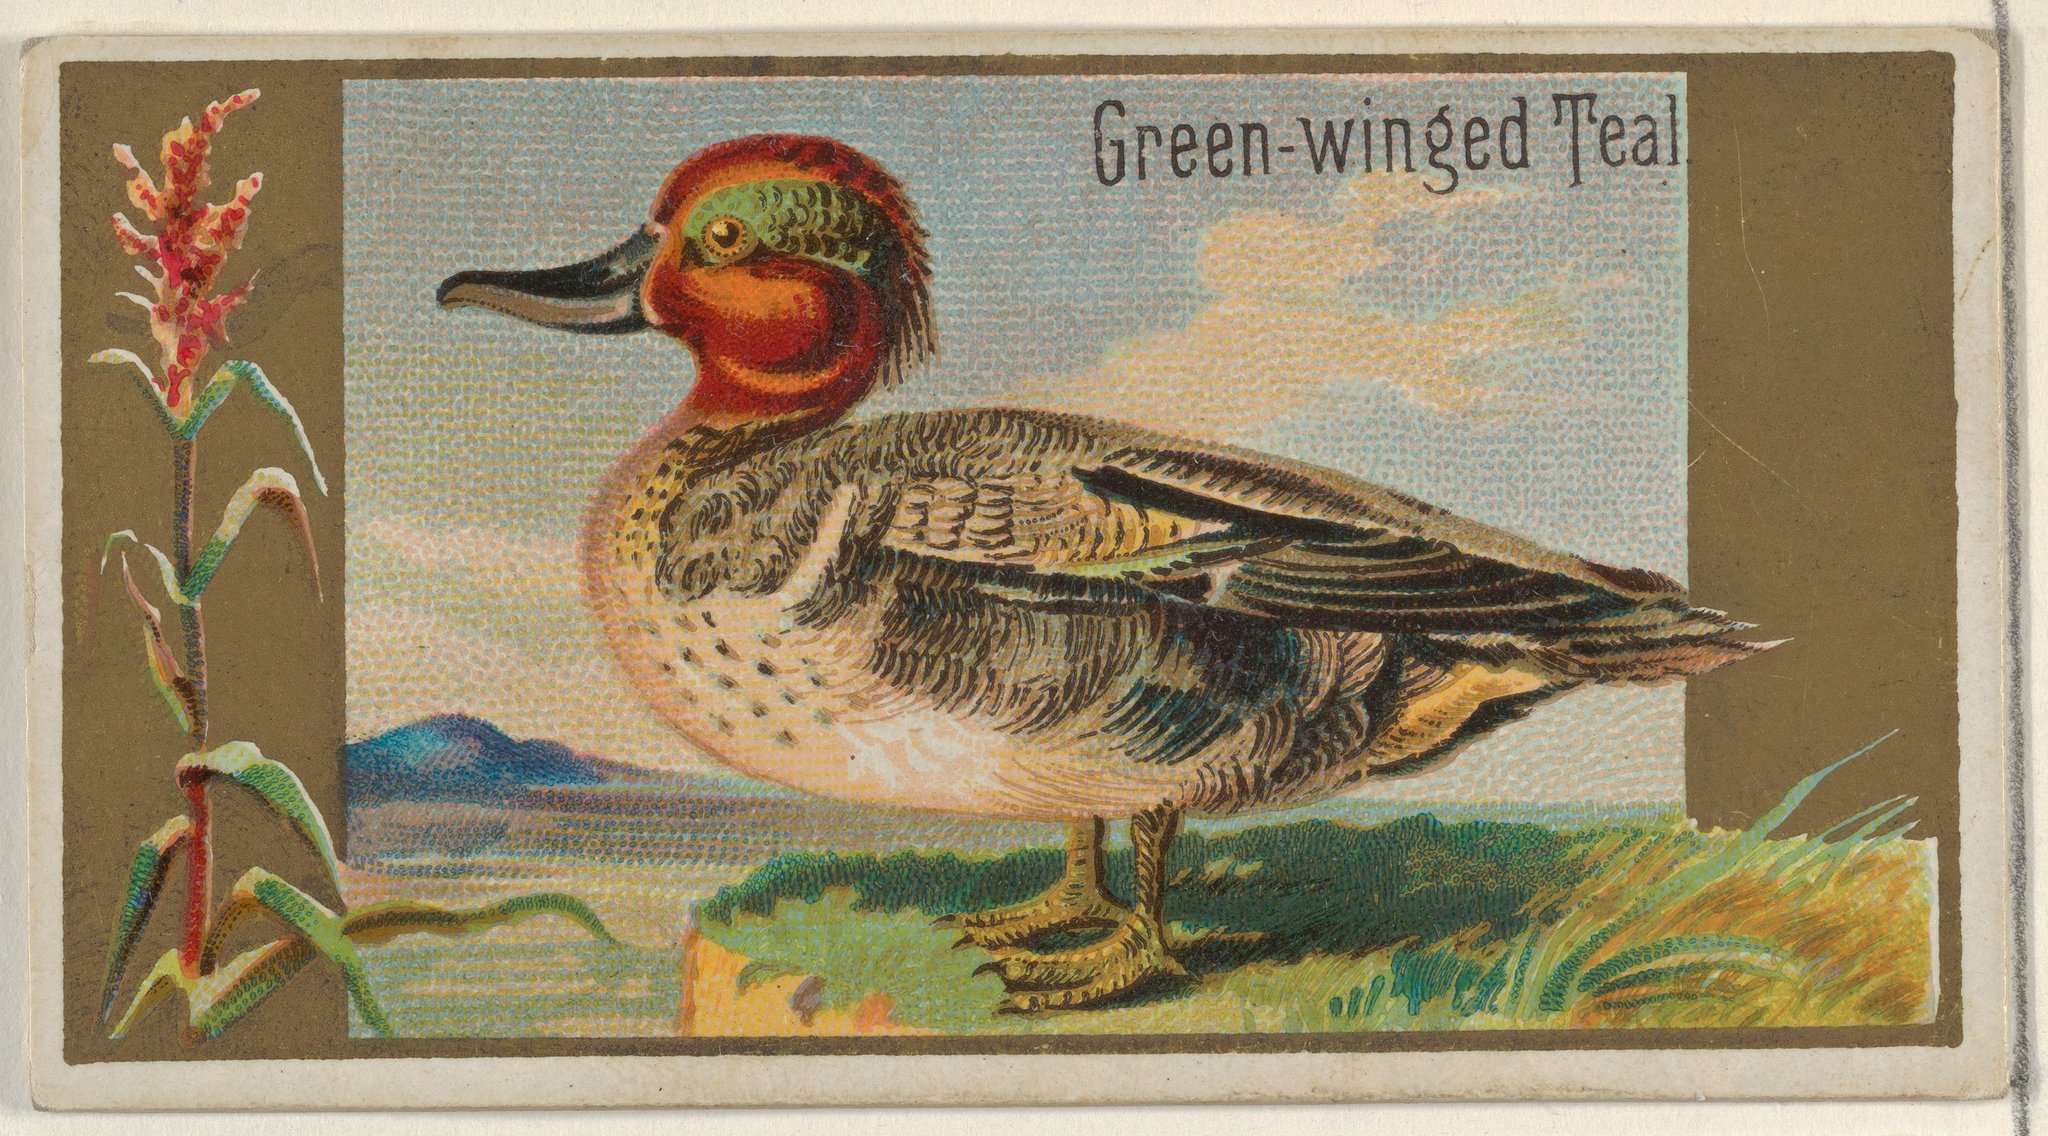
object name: print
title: Green-winged Teal, from the Game Birds series (N13) for Allen & Ginter Cigarettes Brands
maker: allen & ginter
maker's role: publisher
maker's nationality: american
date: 1889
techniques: color lithograph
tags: birds